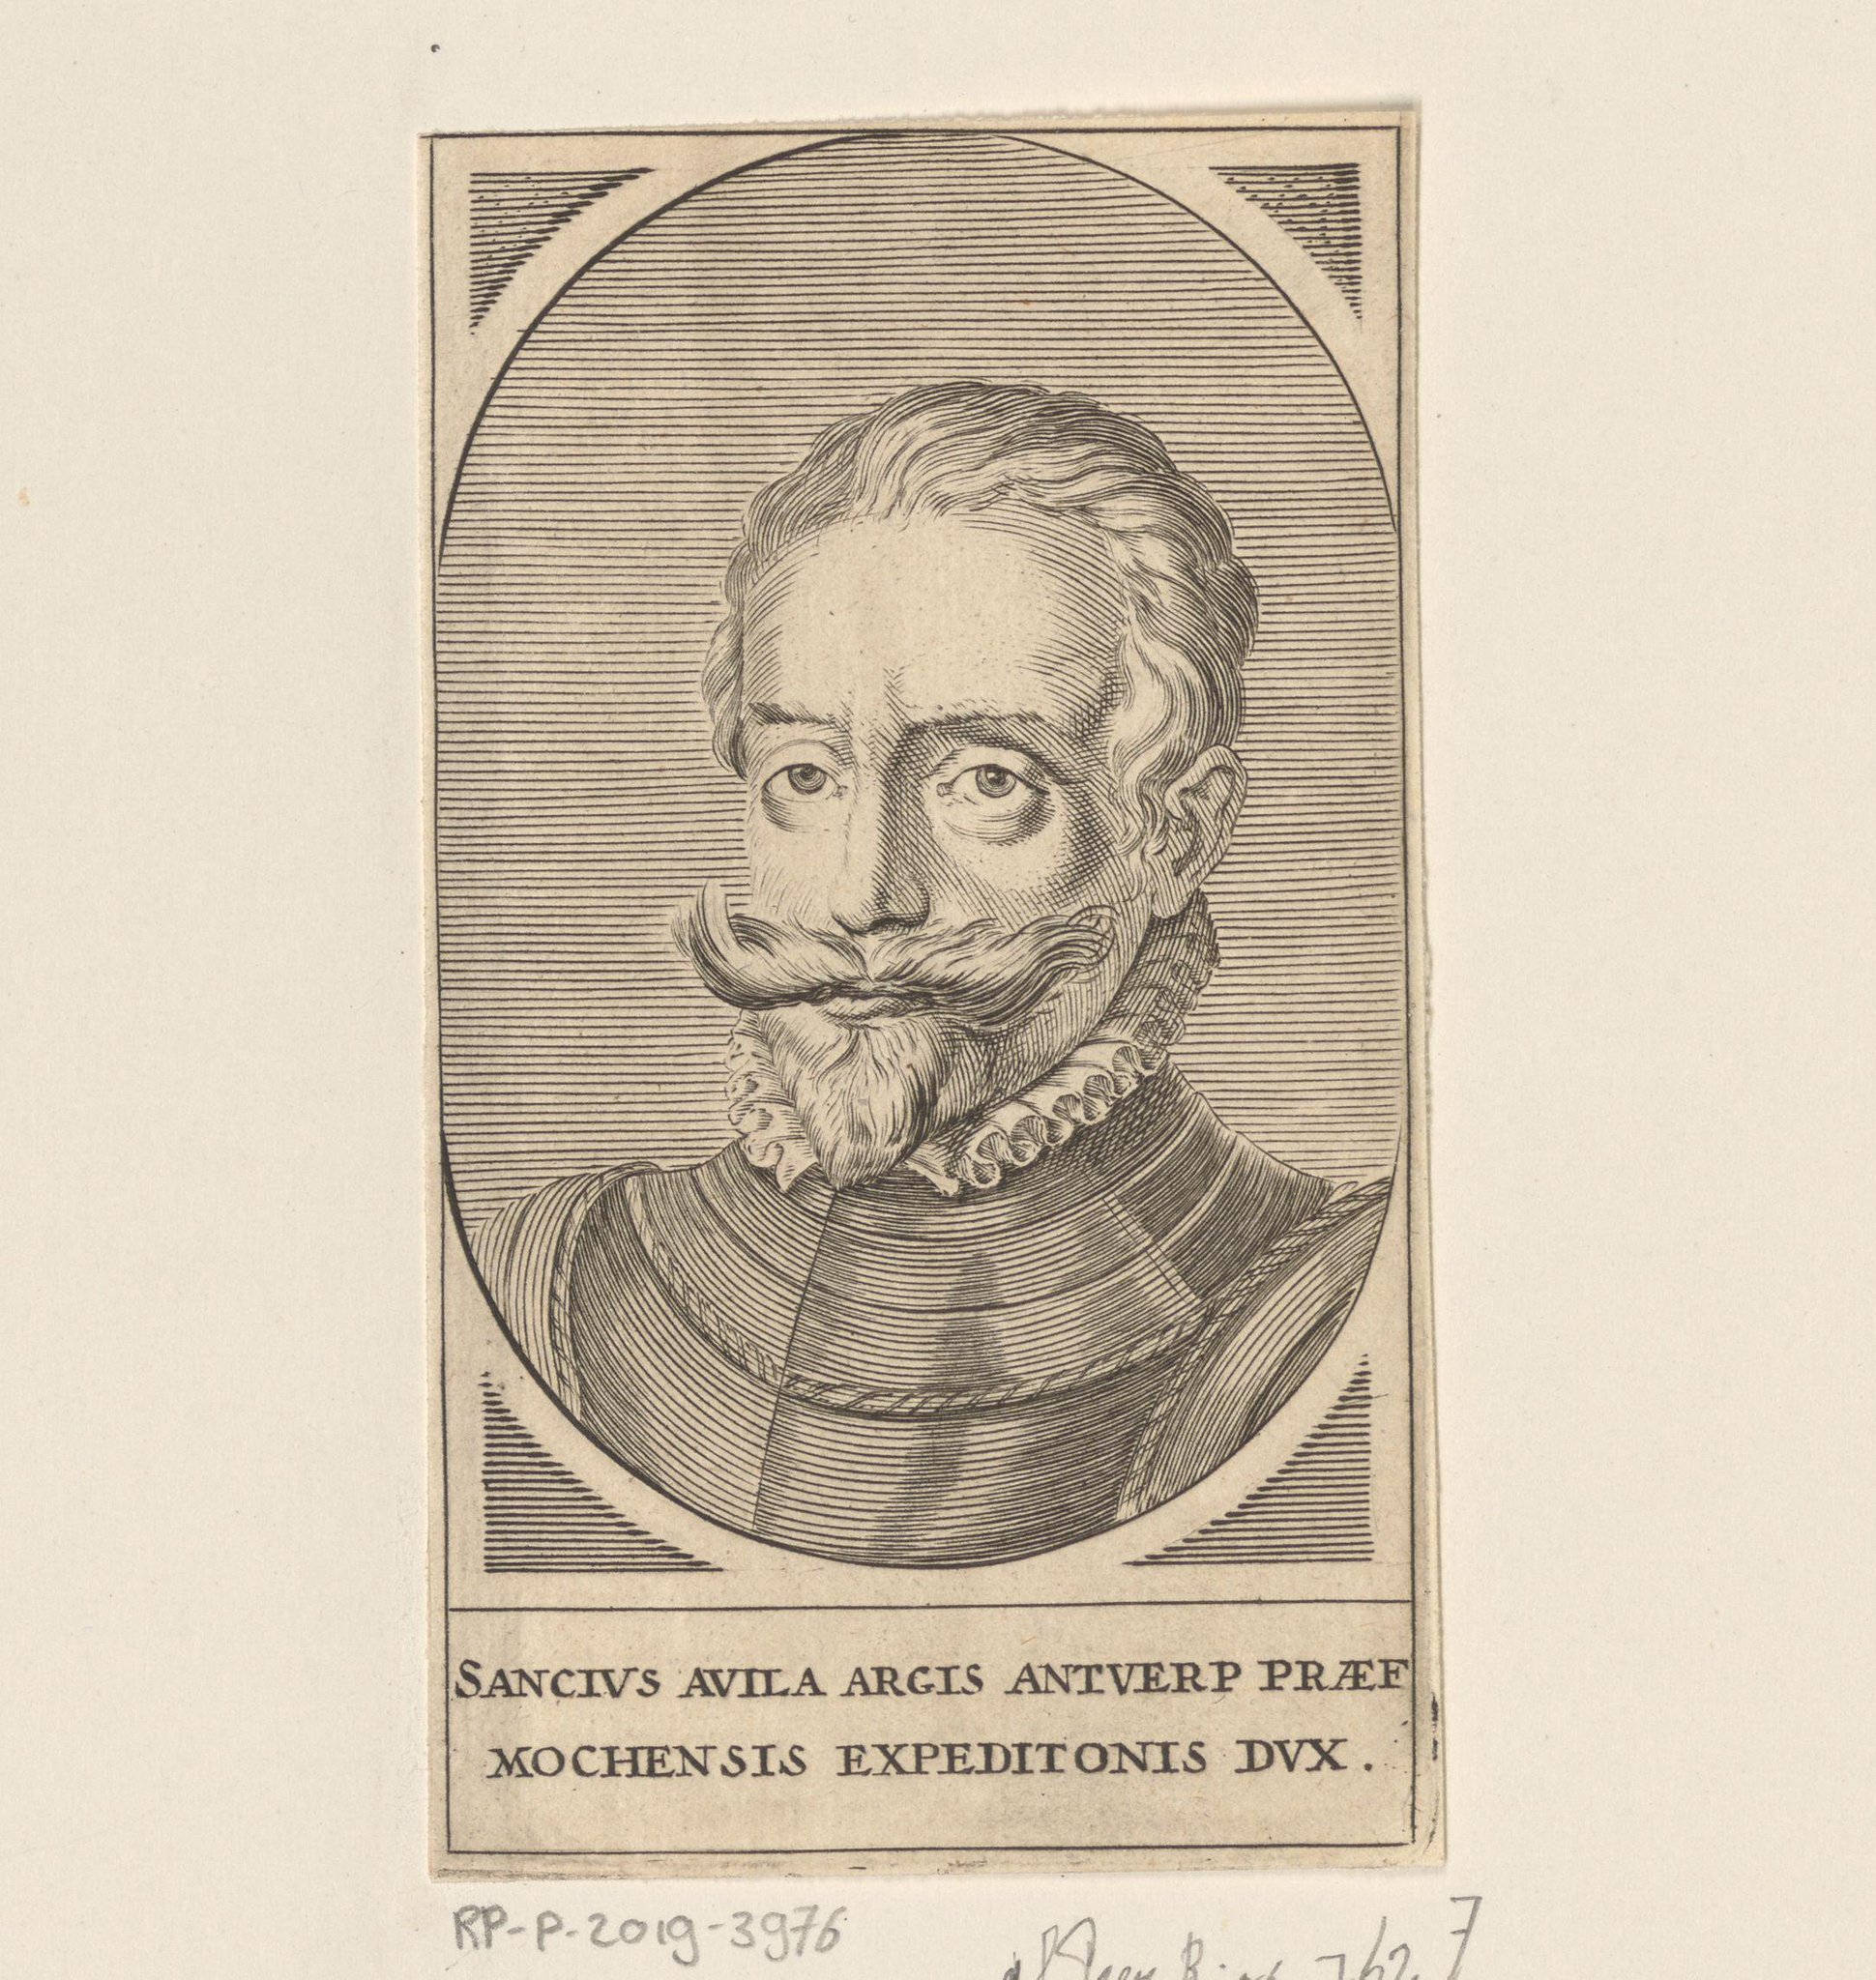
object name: print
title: Portret van Sancho d'Avila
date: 1645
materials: paper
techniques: engraving, etching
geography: leiden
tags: historical persons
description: Prent uit: Strada, Famiano. De bello Belgico decas prima. Leiden: Jacob Marcus, 1645.